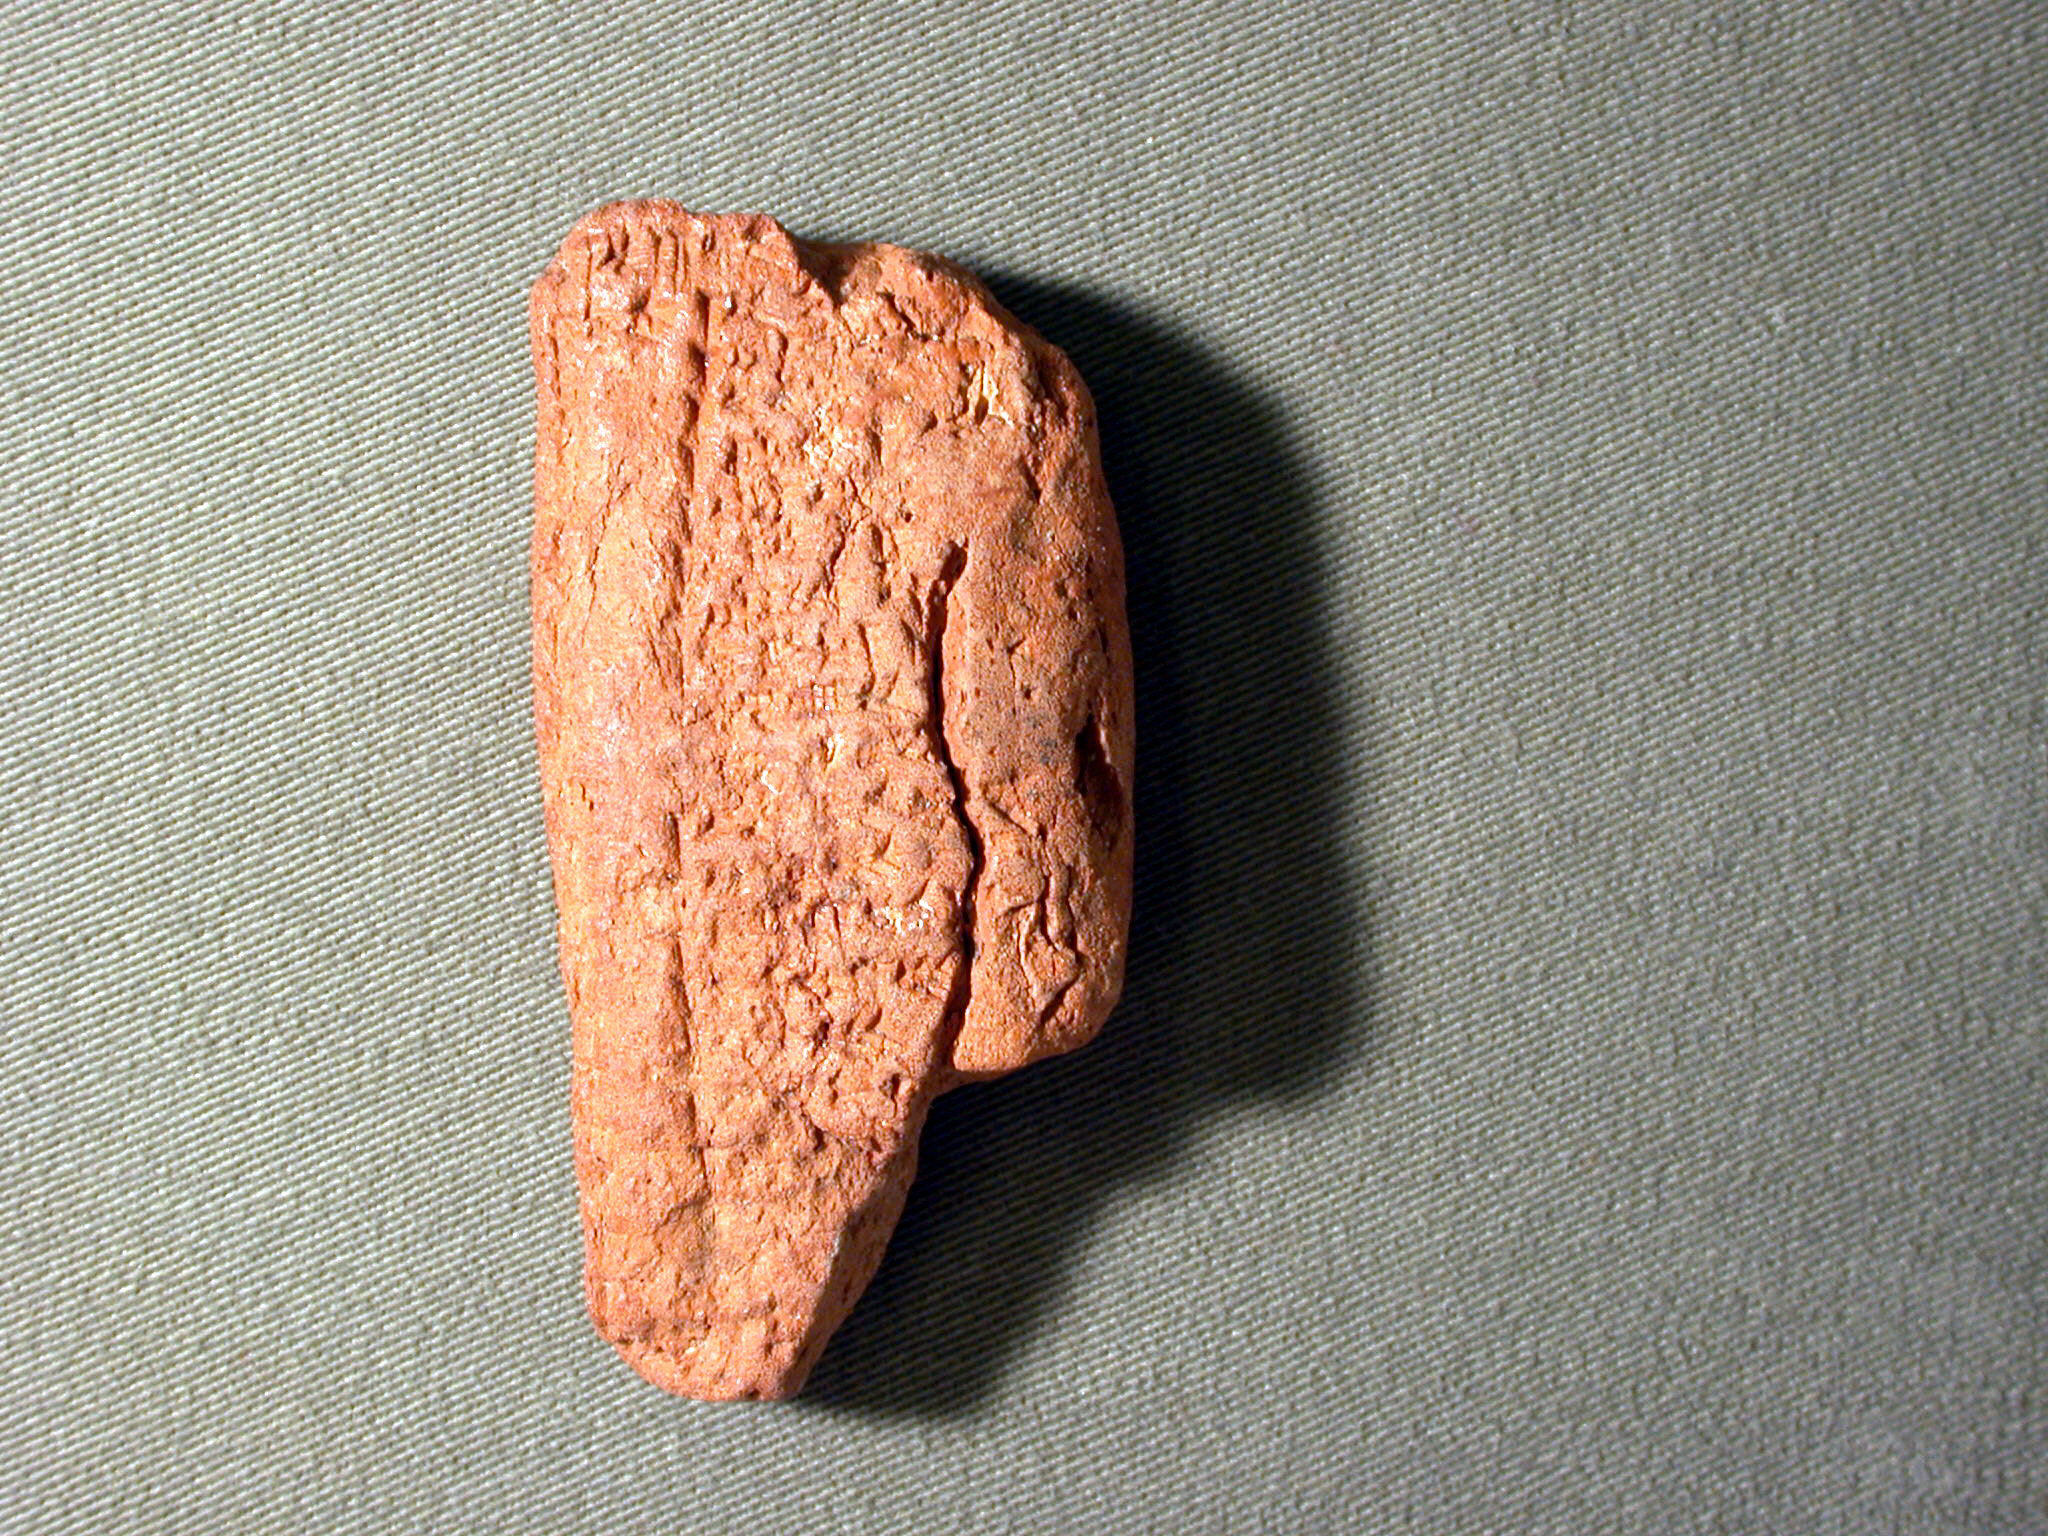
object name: cuneiform tablet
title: Cuneiform tablet: account of commodity allocations, Ebabbar archive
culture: babylonian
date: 700-501 BCE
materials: clay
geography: mesopotamia